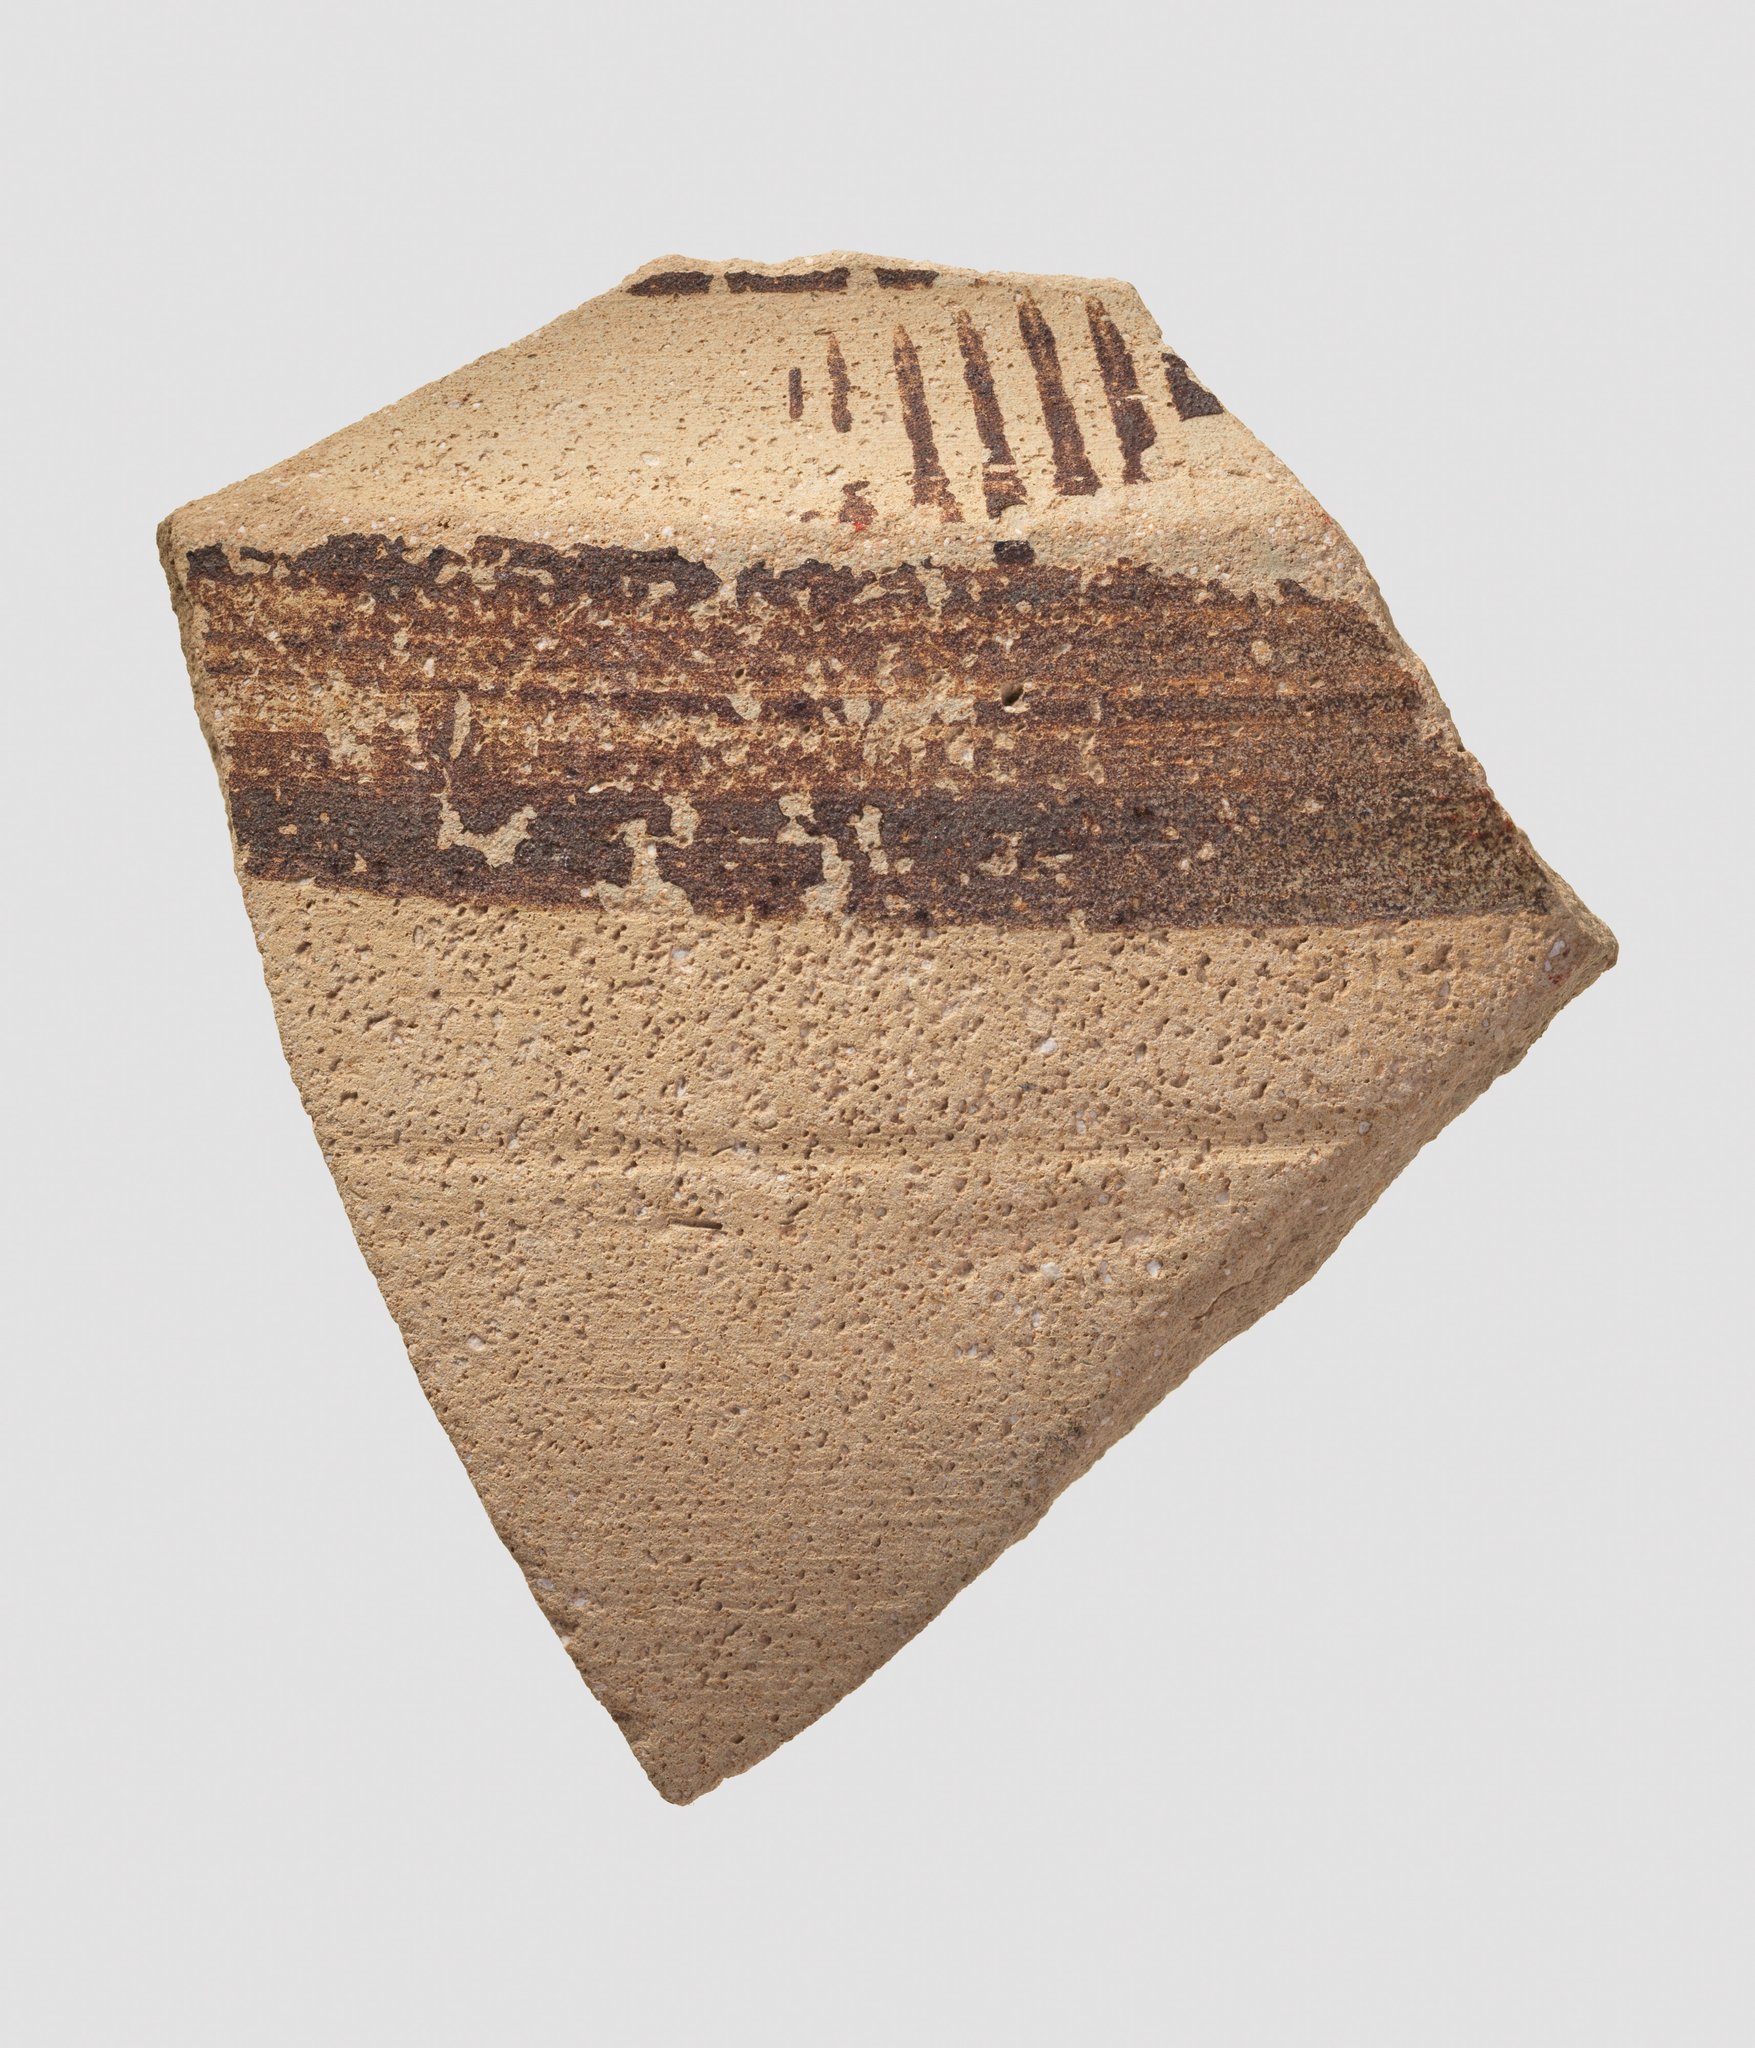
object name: sherd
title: Carinated vessel sherd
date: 2000-1668 BCE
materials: ceramic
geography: mesopotamia